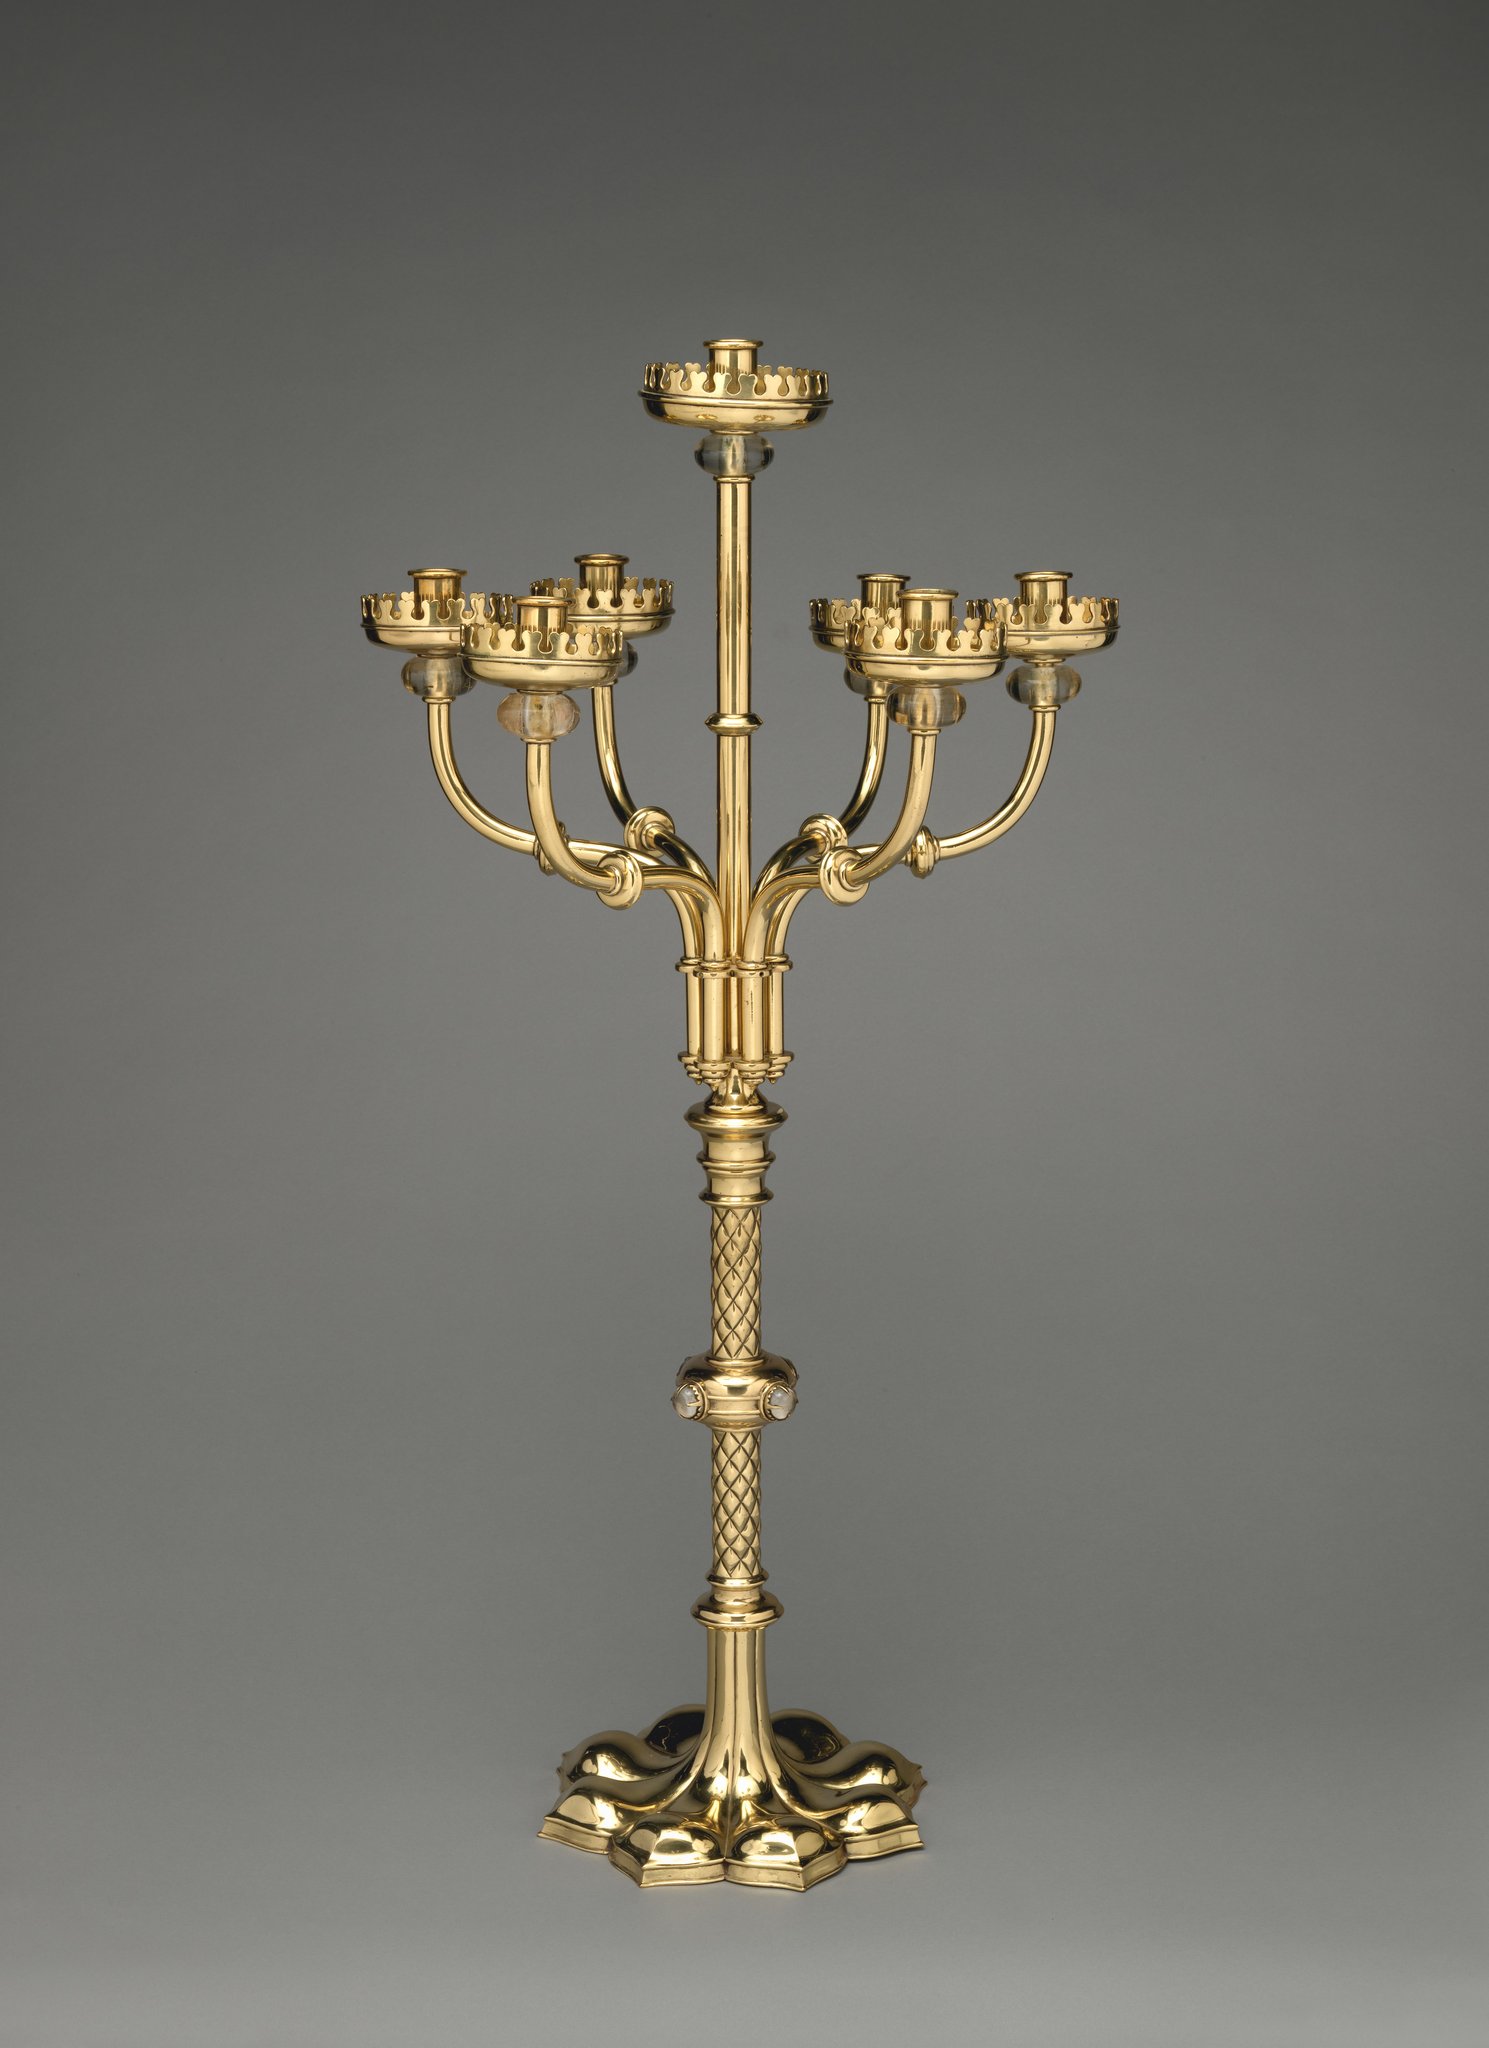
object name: candelabrum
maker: augustus welby northmore pugin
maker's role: designer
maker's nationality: british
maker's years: 1812-1852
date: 1846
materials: gilt brass, glass